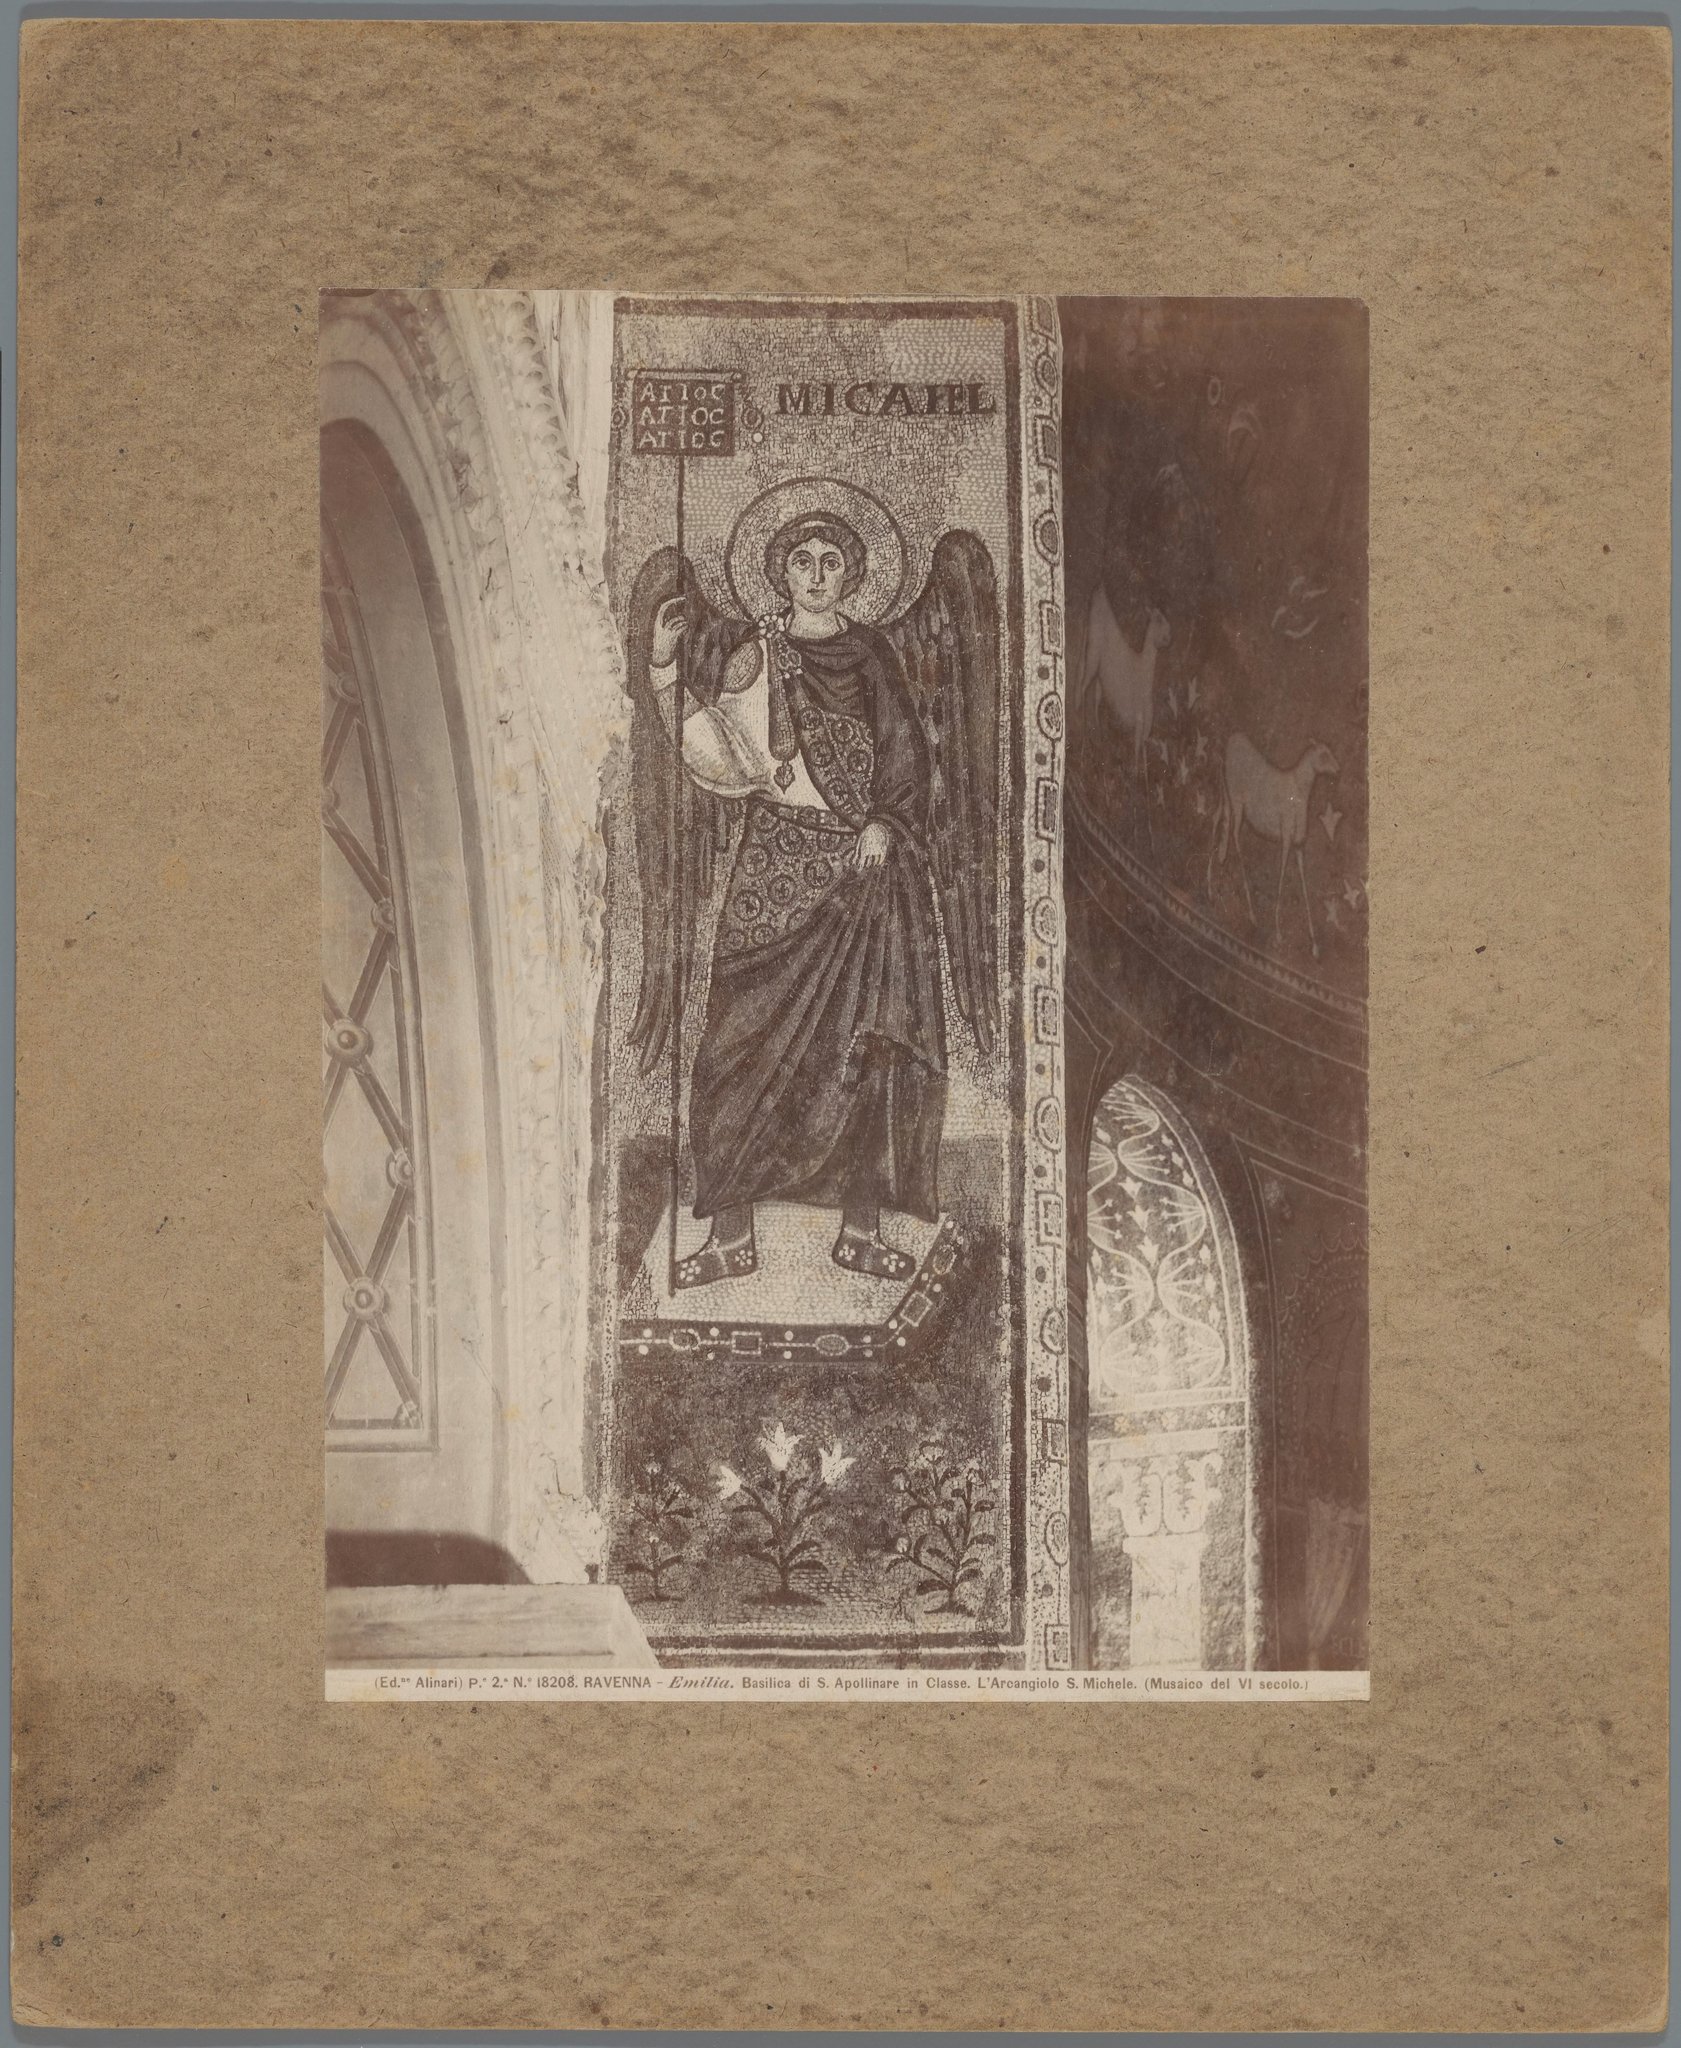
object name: photograph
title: RAVENNA - Emilia. Basilica di S. Apollinare in Classe. L'Arcangiolo S. Michele.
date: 1875-1900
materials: cardboard, photographic support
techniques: albumen print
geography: basiliek van sant'apollinare in classe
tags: the archangel michael (often in armour with sword or lance), art (+ mosaic making), interior of church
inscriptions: collector's mark: Lugt 3937, number: ‘P.e 2.a N.o 18208.’